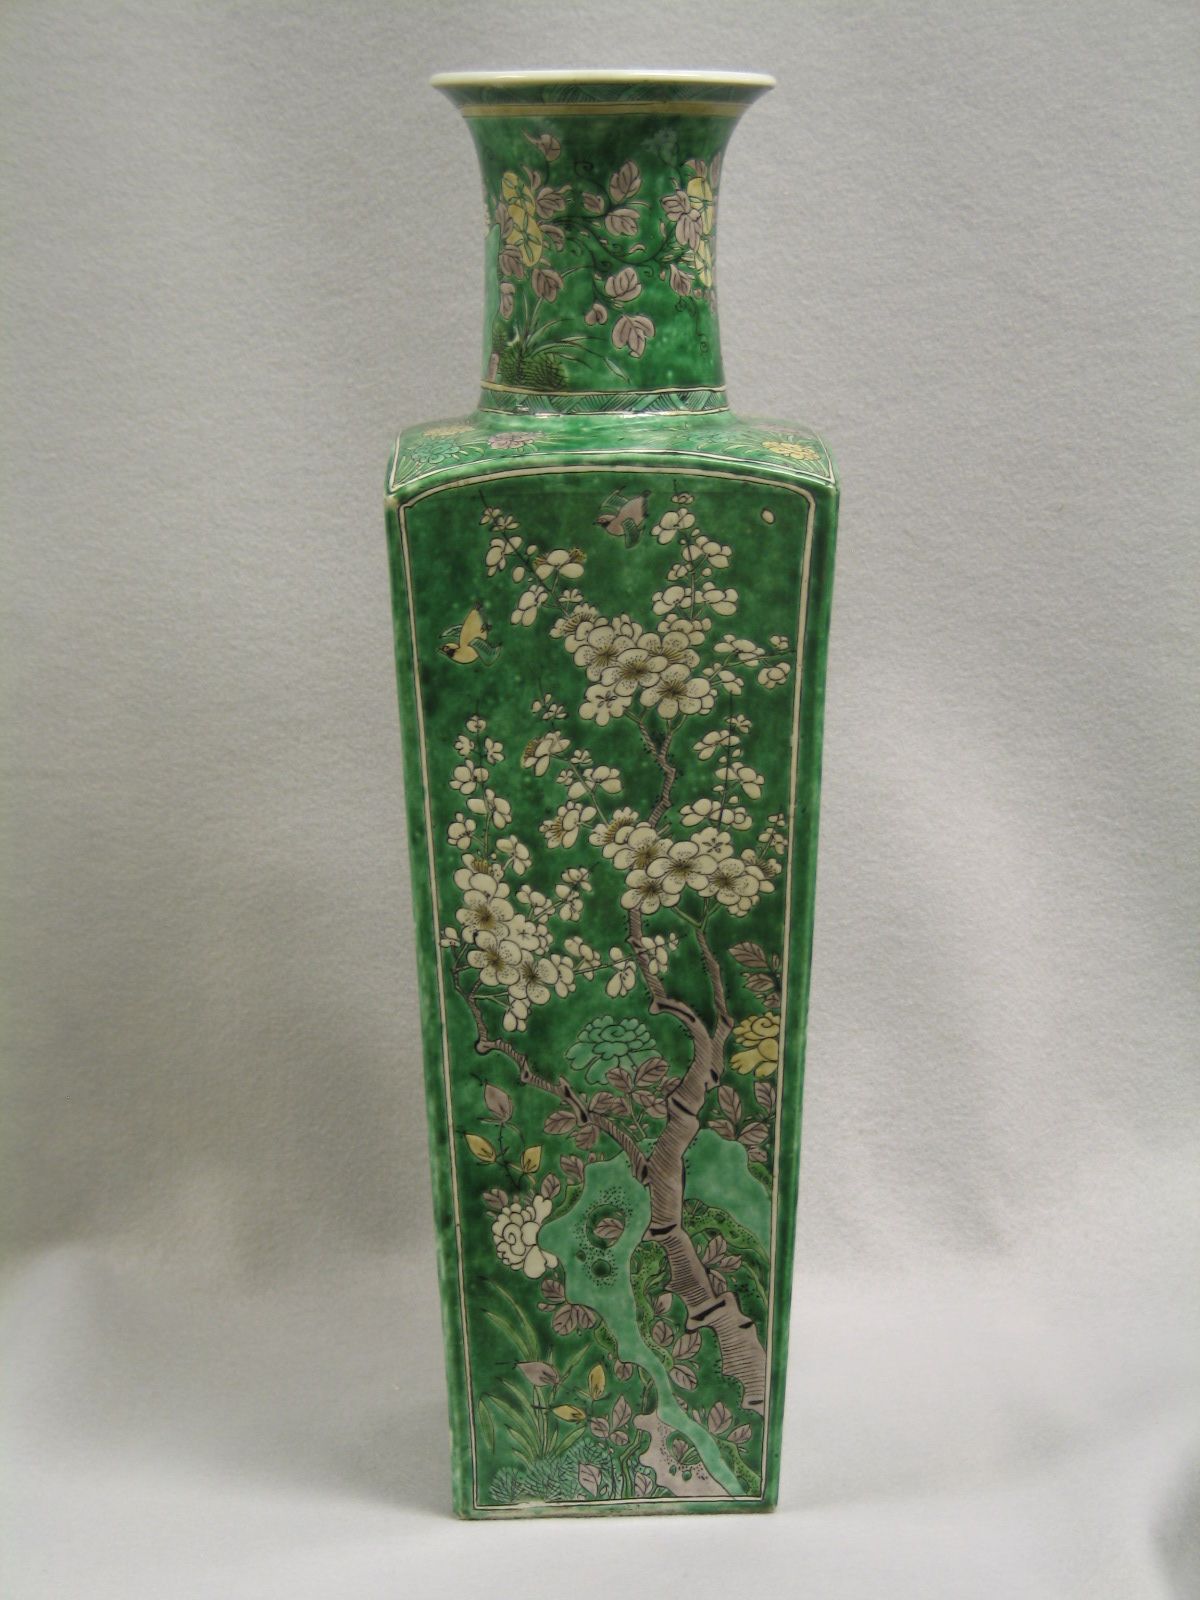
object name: vase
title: Vase (one of a pair)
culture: chinese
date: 1644-1911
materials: enamel, porcelain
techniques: overglaze, painting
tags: birds,flowers,trees